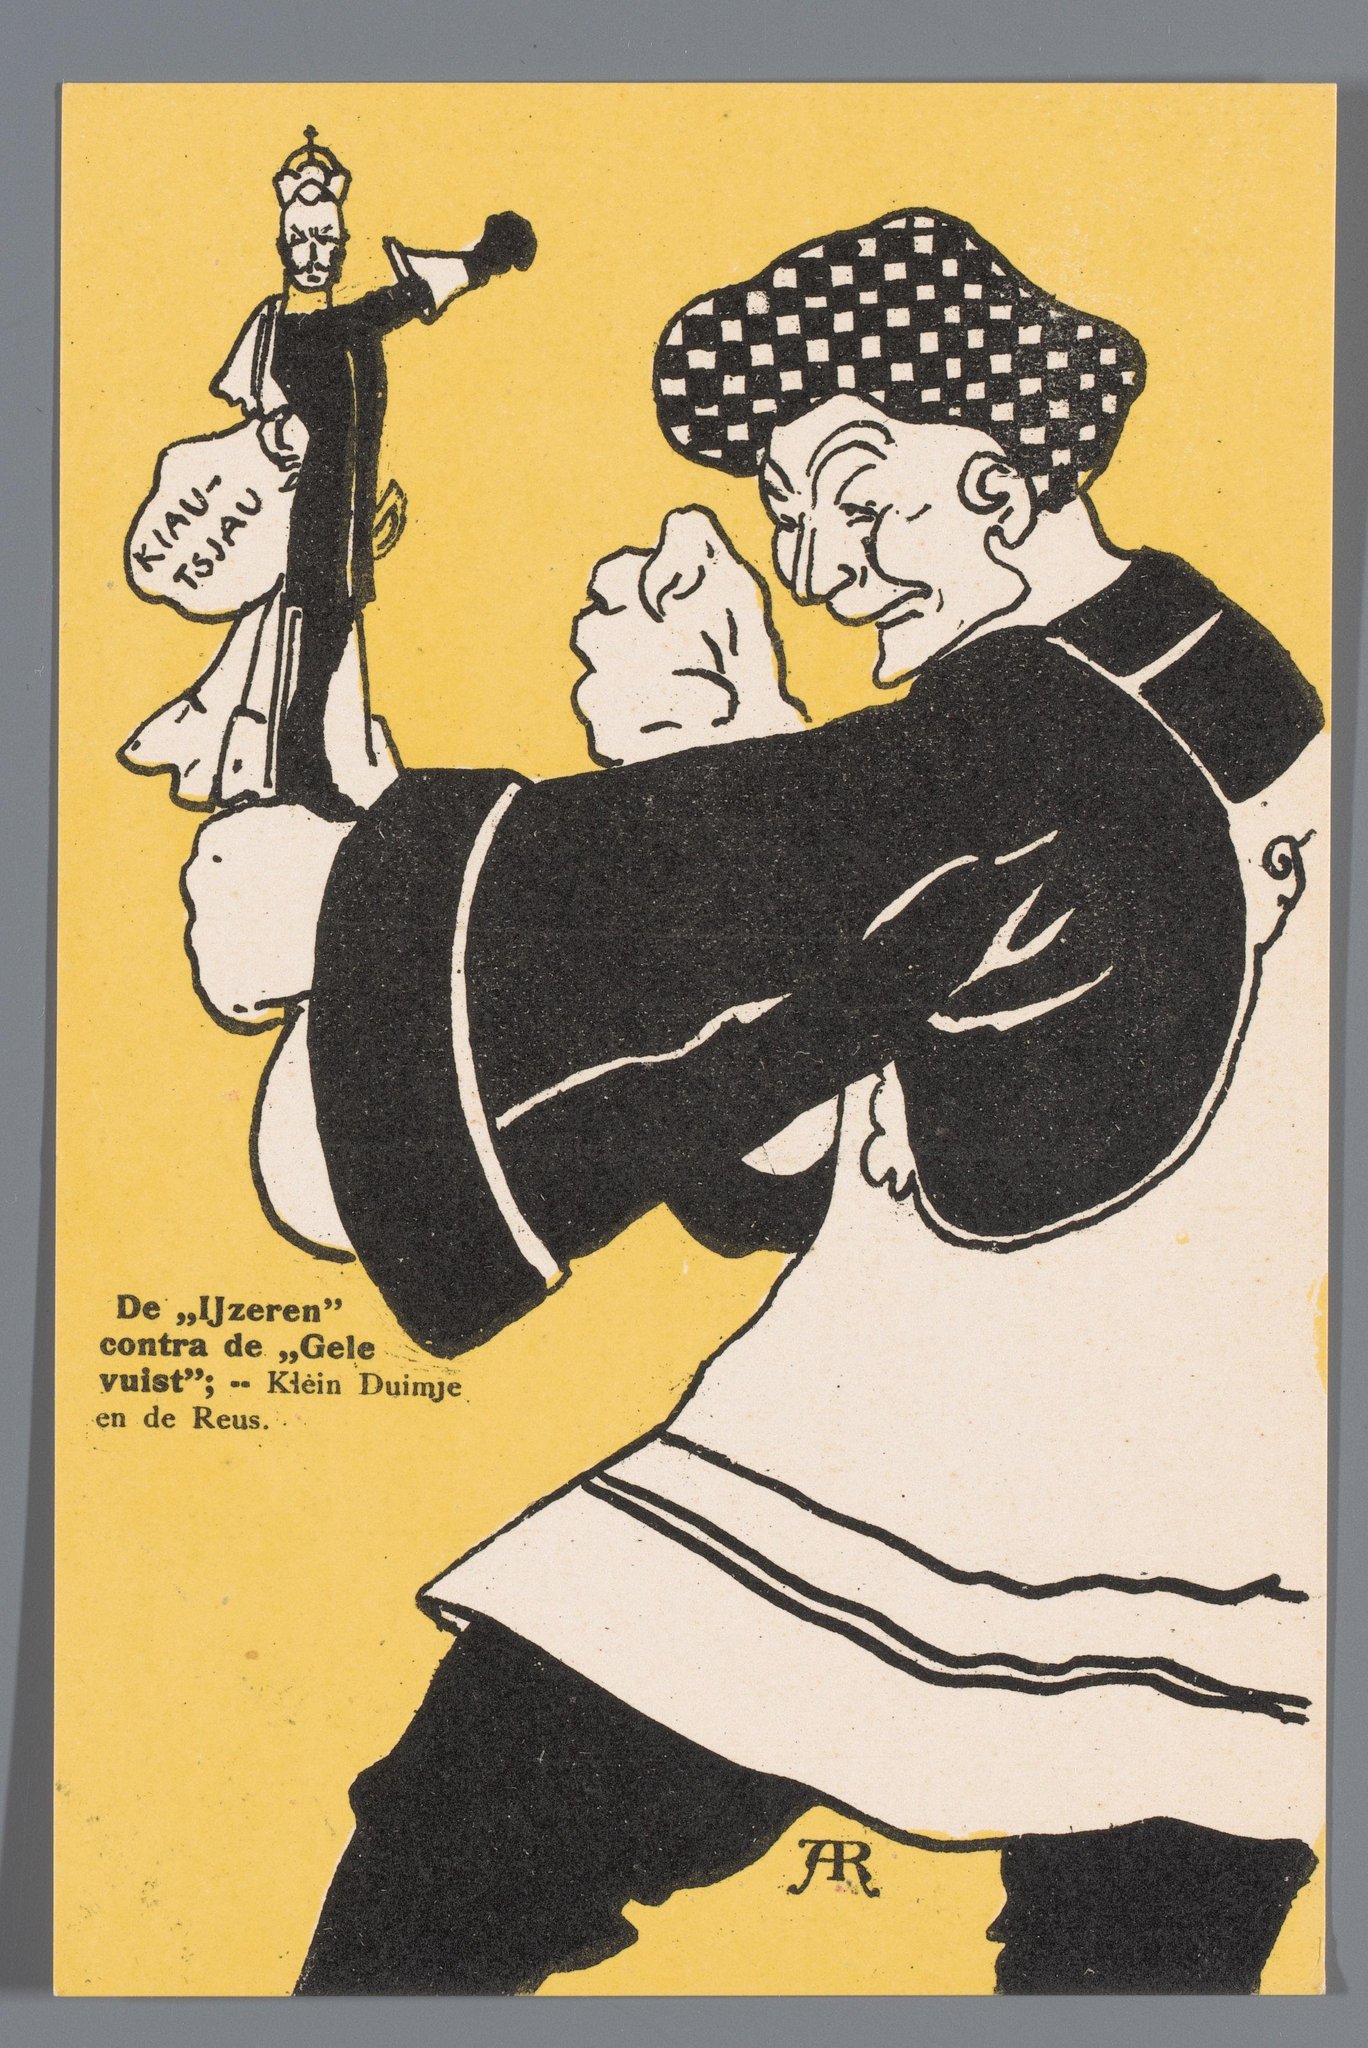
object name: ansichtkaart, prentbriefkaart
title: China prentbriefkaart 'De IJzeren contra de Gele vuist'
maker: alfaro reijding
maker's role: draughtsman, engineer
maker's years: 1863-1930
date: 1900-1918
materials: paper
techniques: printing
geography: netherlands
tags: political caricatures and satires, china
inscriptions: : ‘De "IJzeren" / contra de "Gele / vuist"; .. Klein Duimje / en de Reus.’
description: Prentbriefkaart in zwart en geel met Chinees die een kleine man op zijn hand draagt.